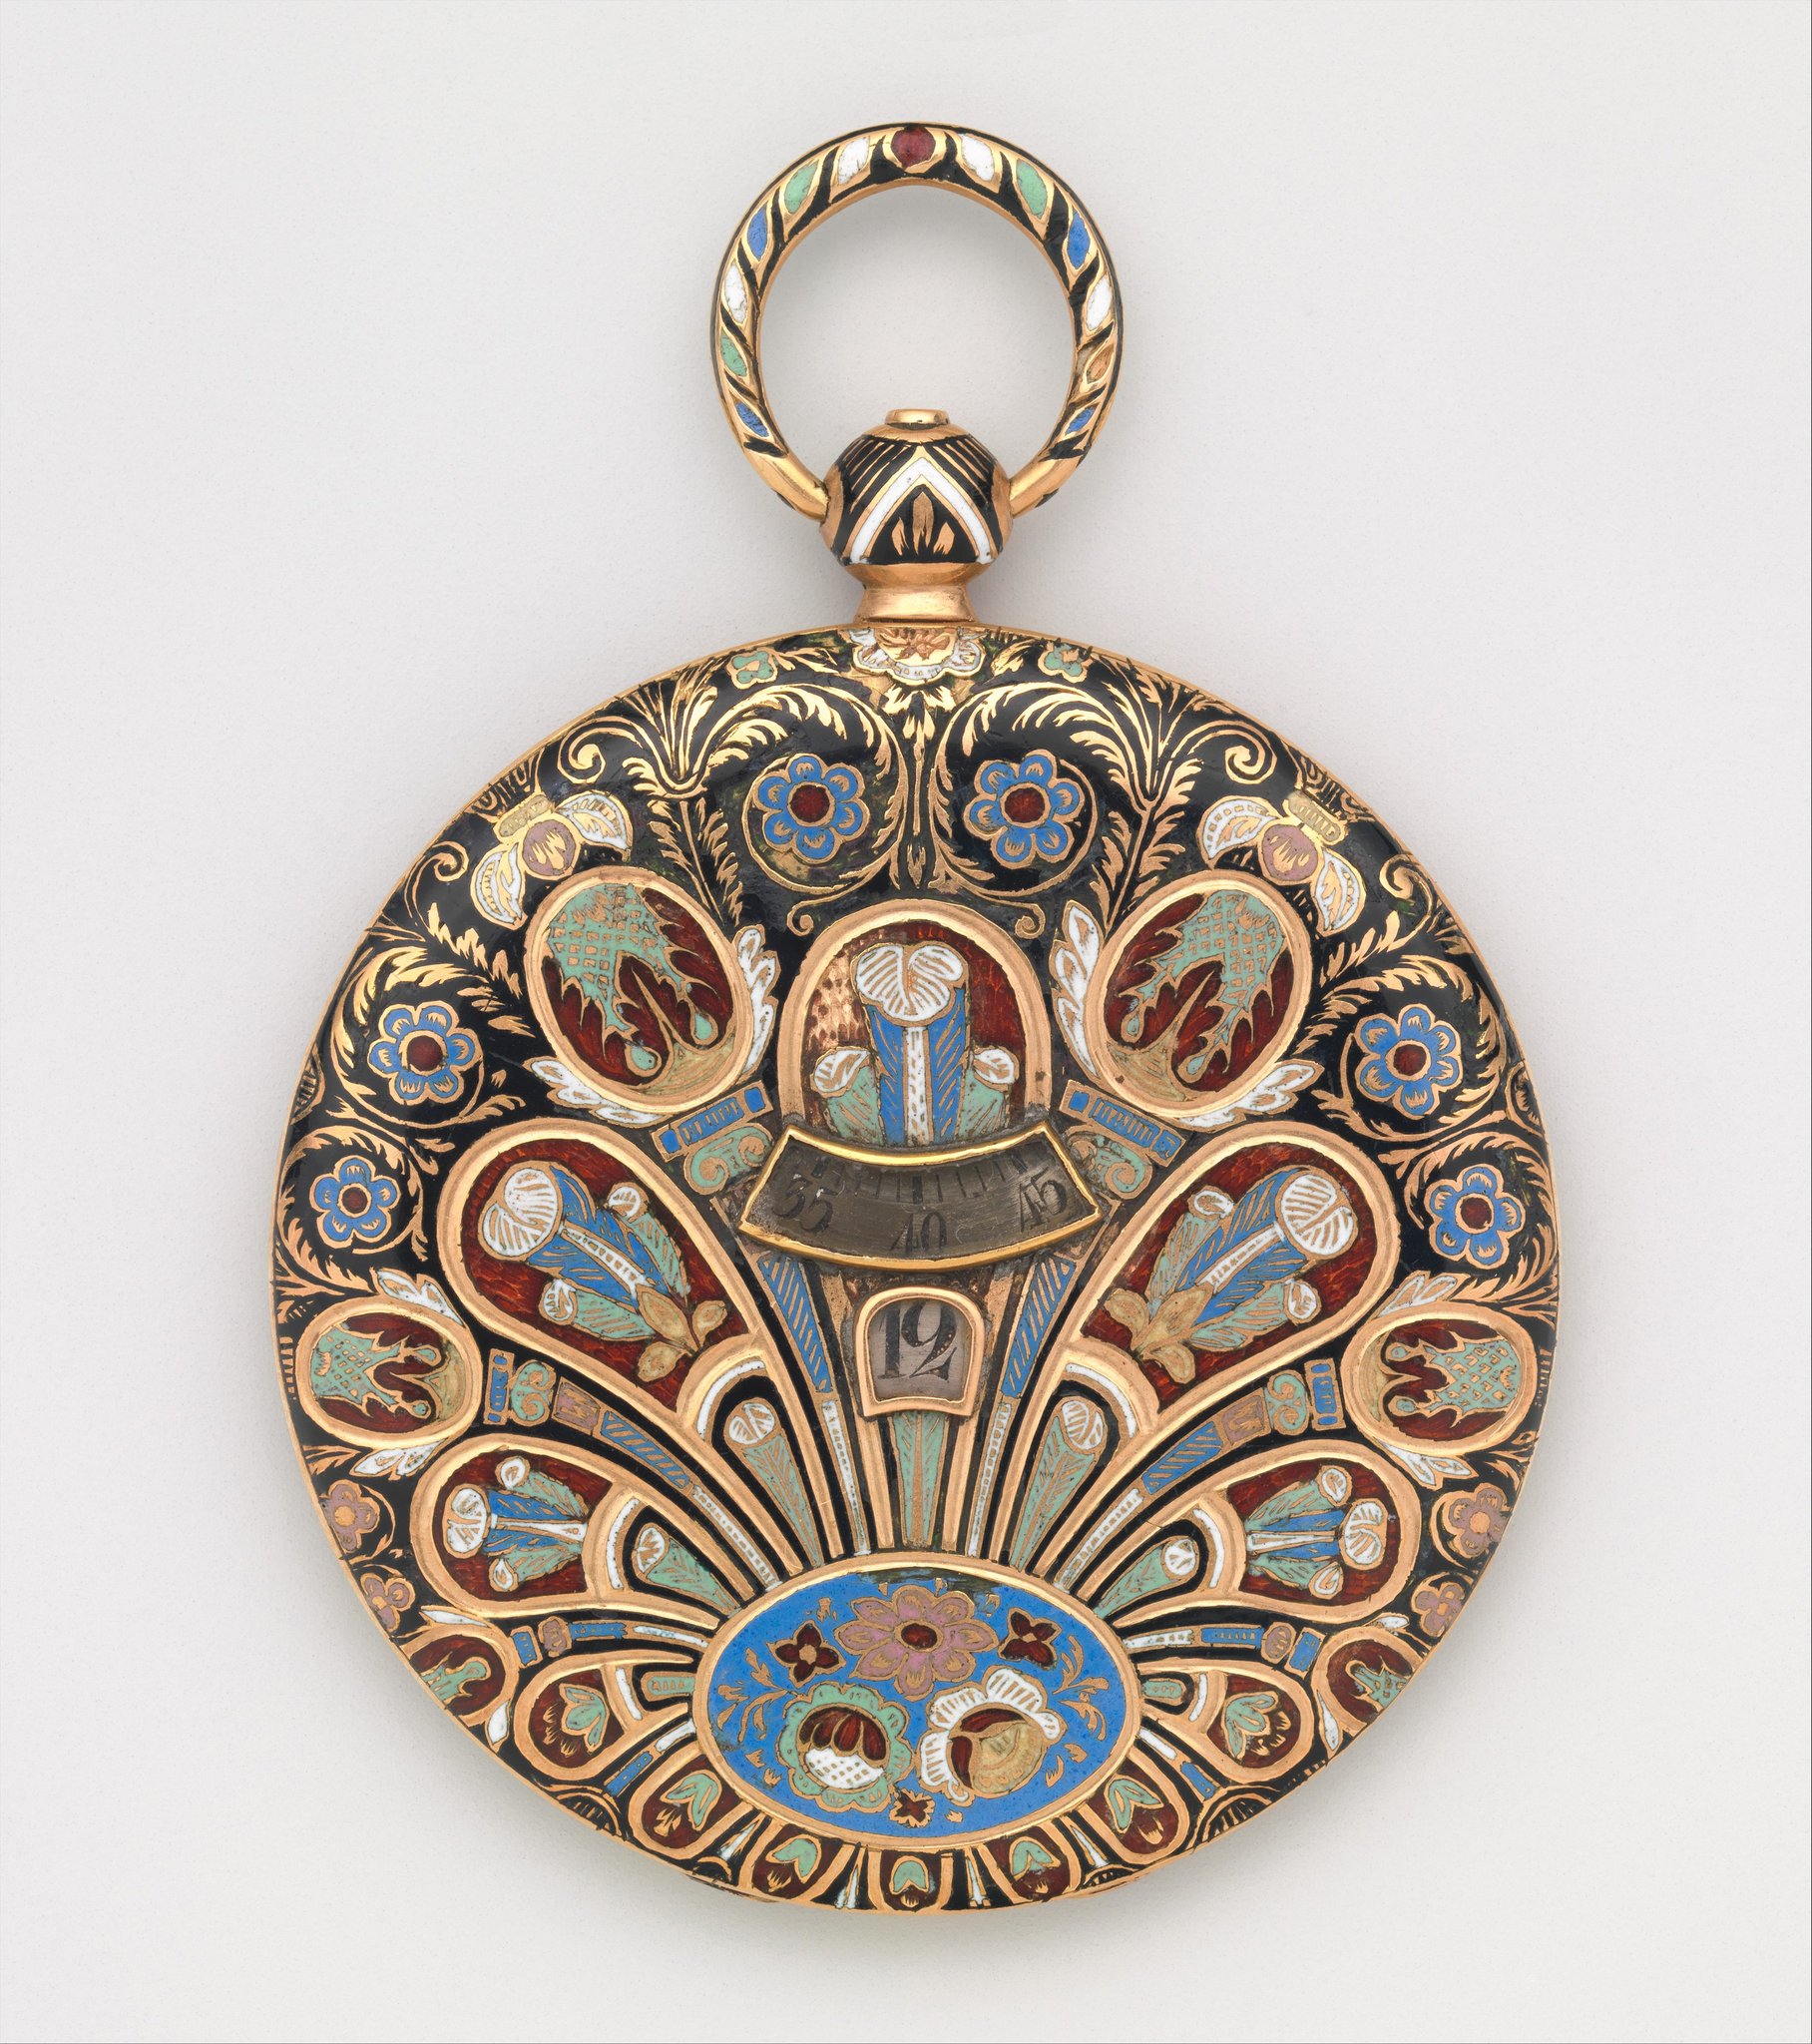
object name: watch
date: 1820-1830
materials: enamel, gold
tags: flowers